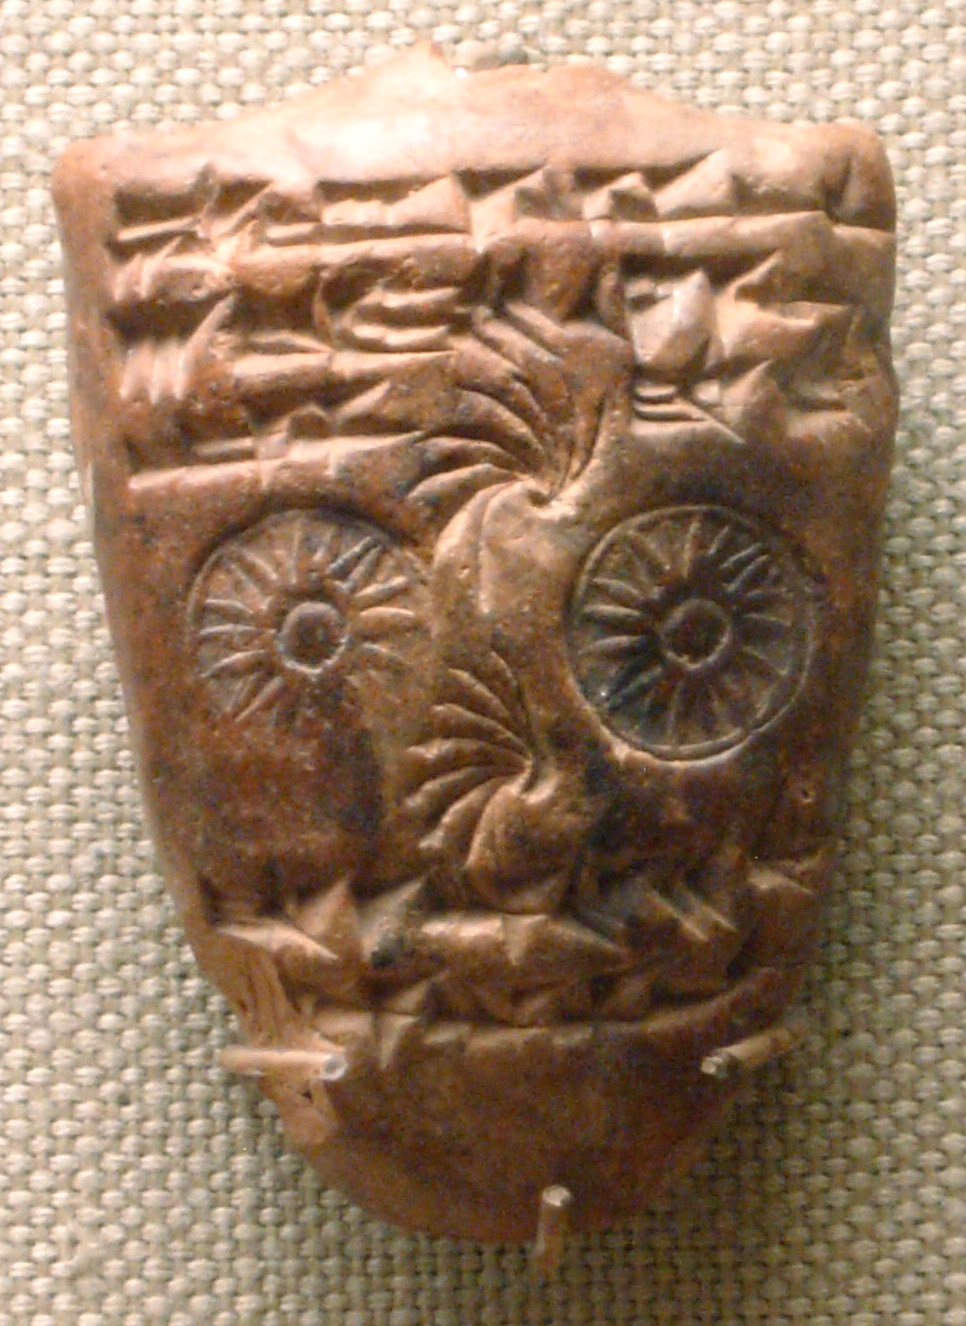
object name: cuneiform tablet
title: Triangular label impressed with stamp seal: for grain loan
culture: assyrian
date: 700-601 BCE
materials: clay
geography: mesopotamia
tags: faces